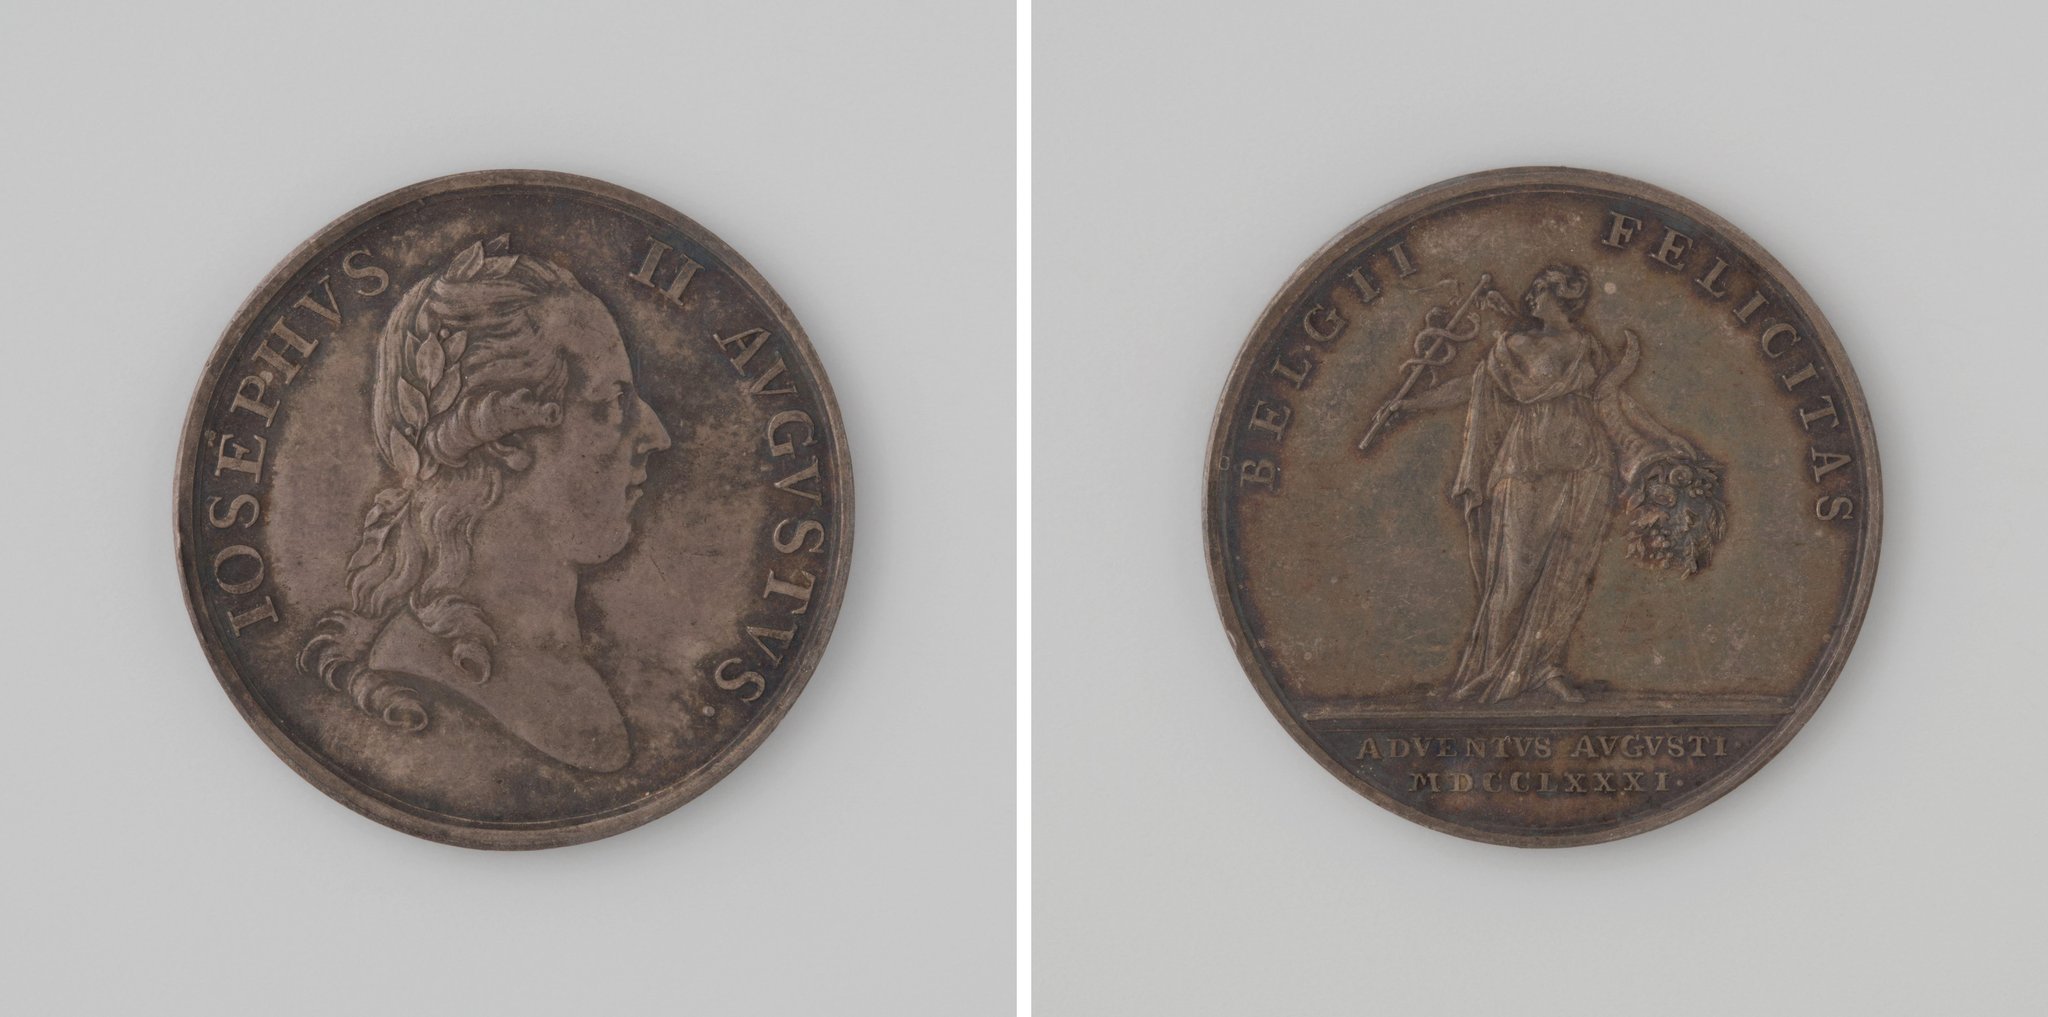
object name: history medal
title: Aankomst van Jozef II, Duits keizer in de Oostenrijkse Nederlanden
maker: theodorus victor van berckel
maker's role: mintmaster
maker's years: 1739-1808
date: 1781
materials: silver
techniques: striking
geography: brussels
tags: vienna, jozef ii (duits keizer), belgium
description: Zilveren penning. Voorzijde: borststuk man met lauwerkrans binnen omschrift. Keerzijde: vrouw met Mercuriusstaf en gevulde hoorn van overvloed, voorstellende Belgie binnen omschrift; afsnede: opschrift